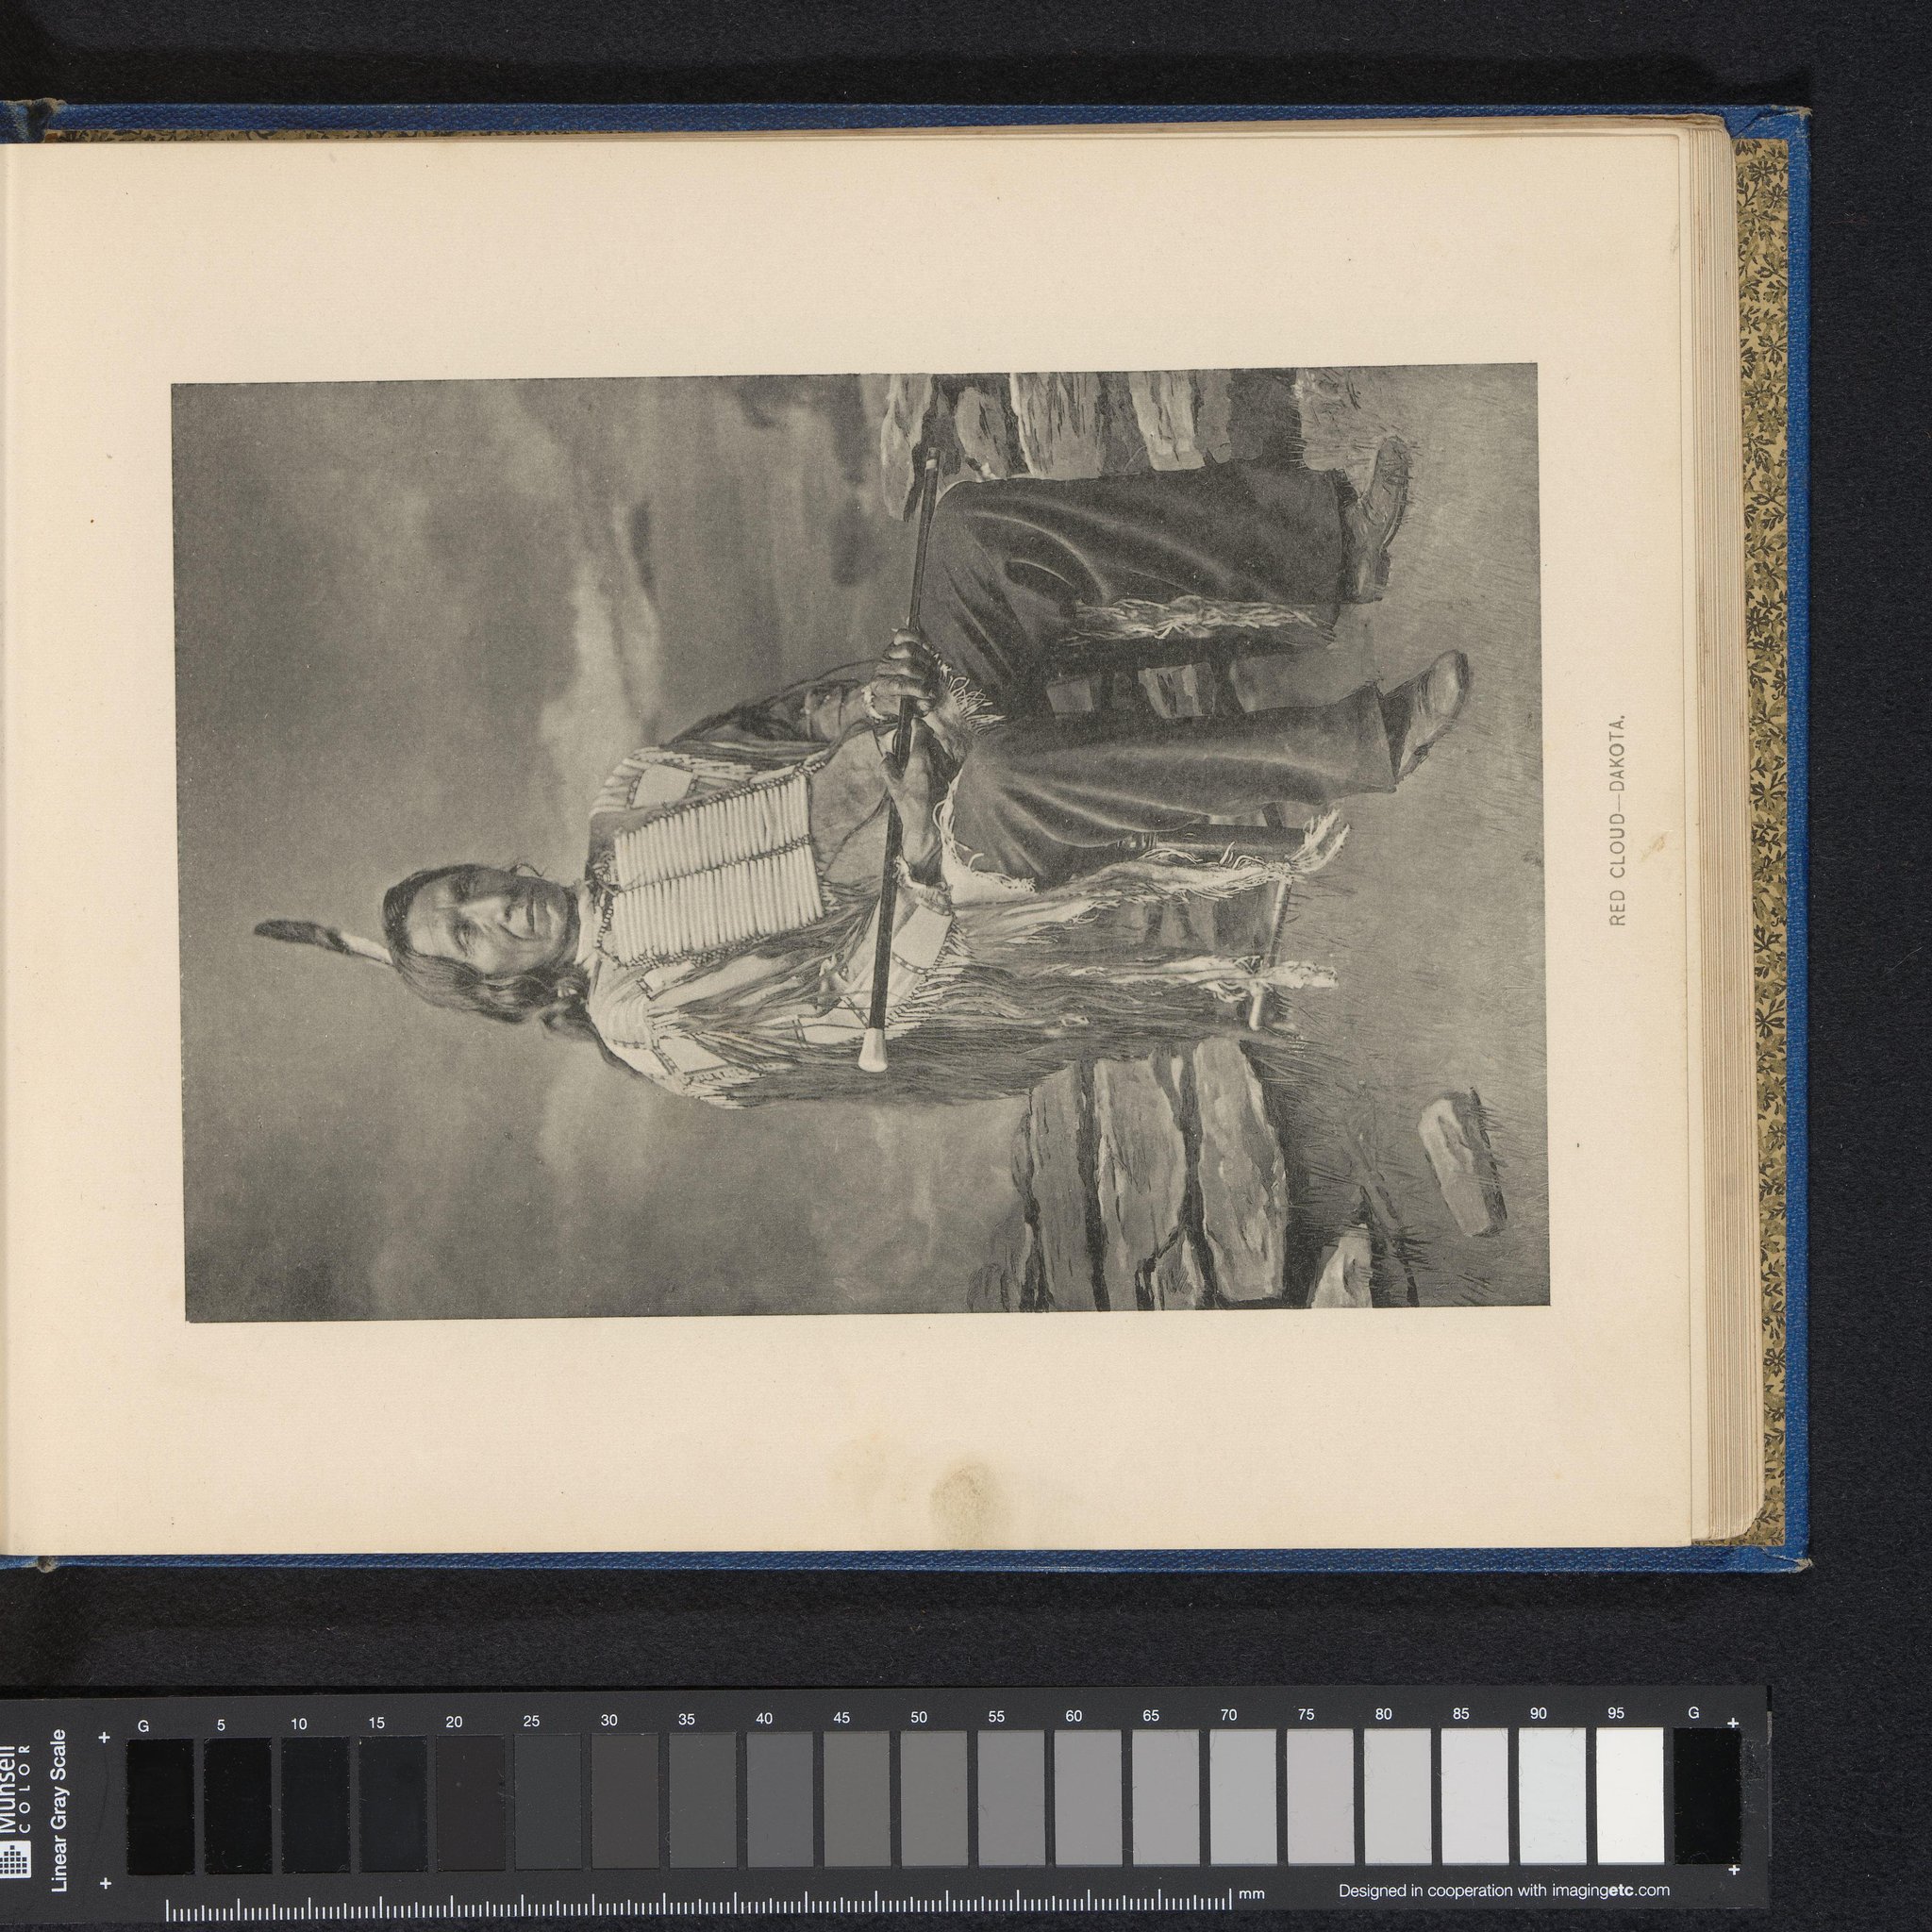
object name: photomechanical print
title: Red Cloud- Dakota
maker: Anonymous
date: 1883-1893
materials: paper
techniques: photograph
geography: united states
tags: indigenous peoples of north america